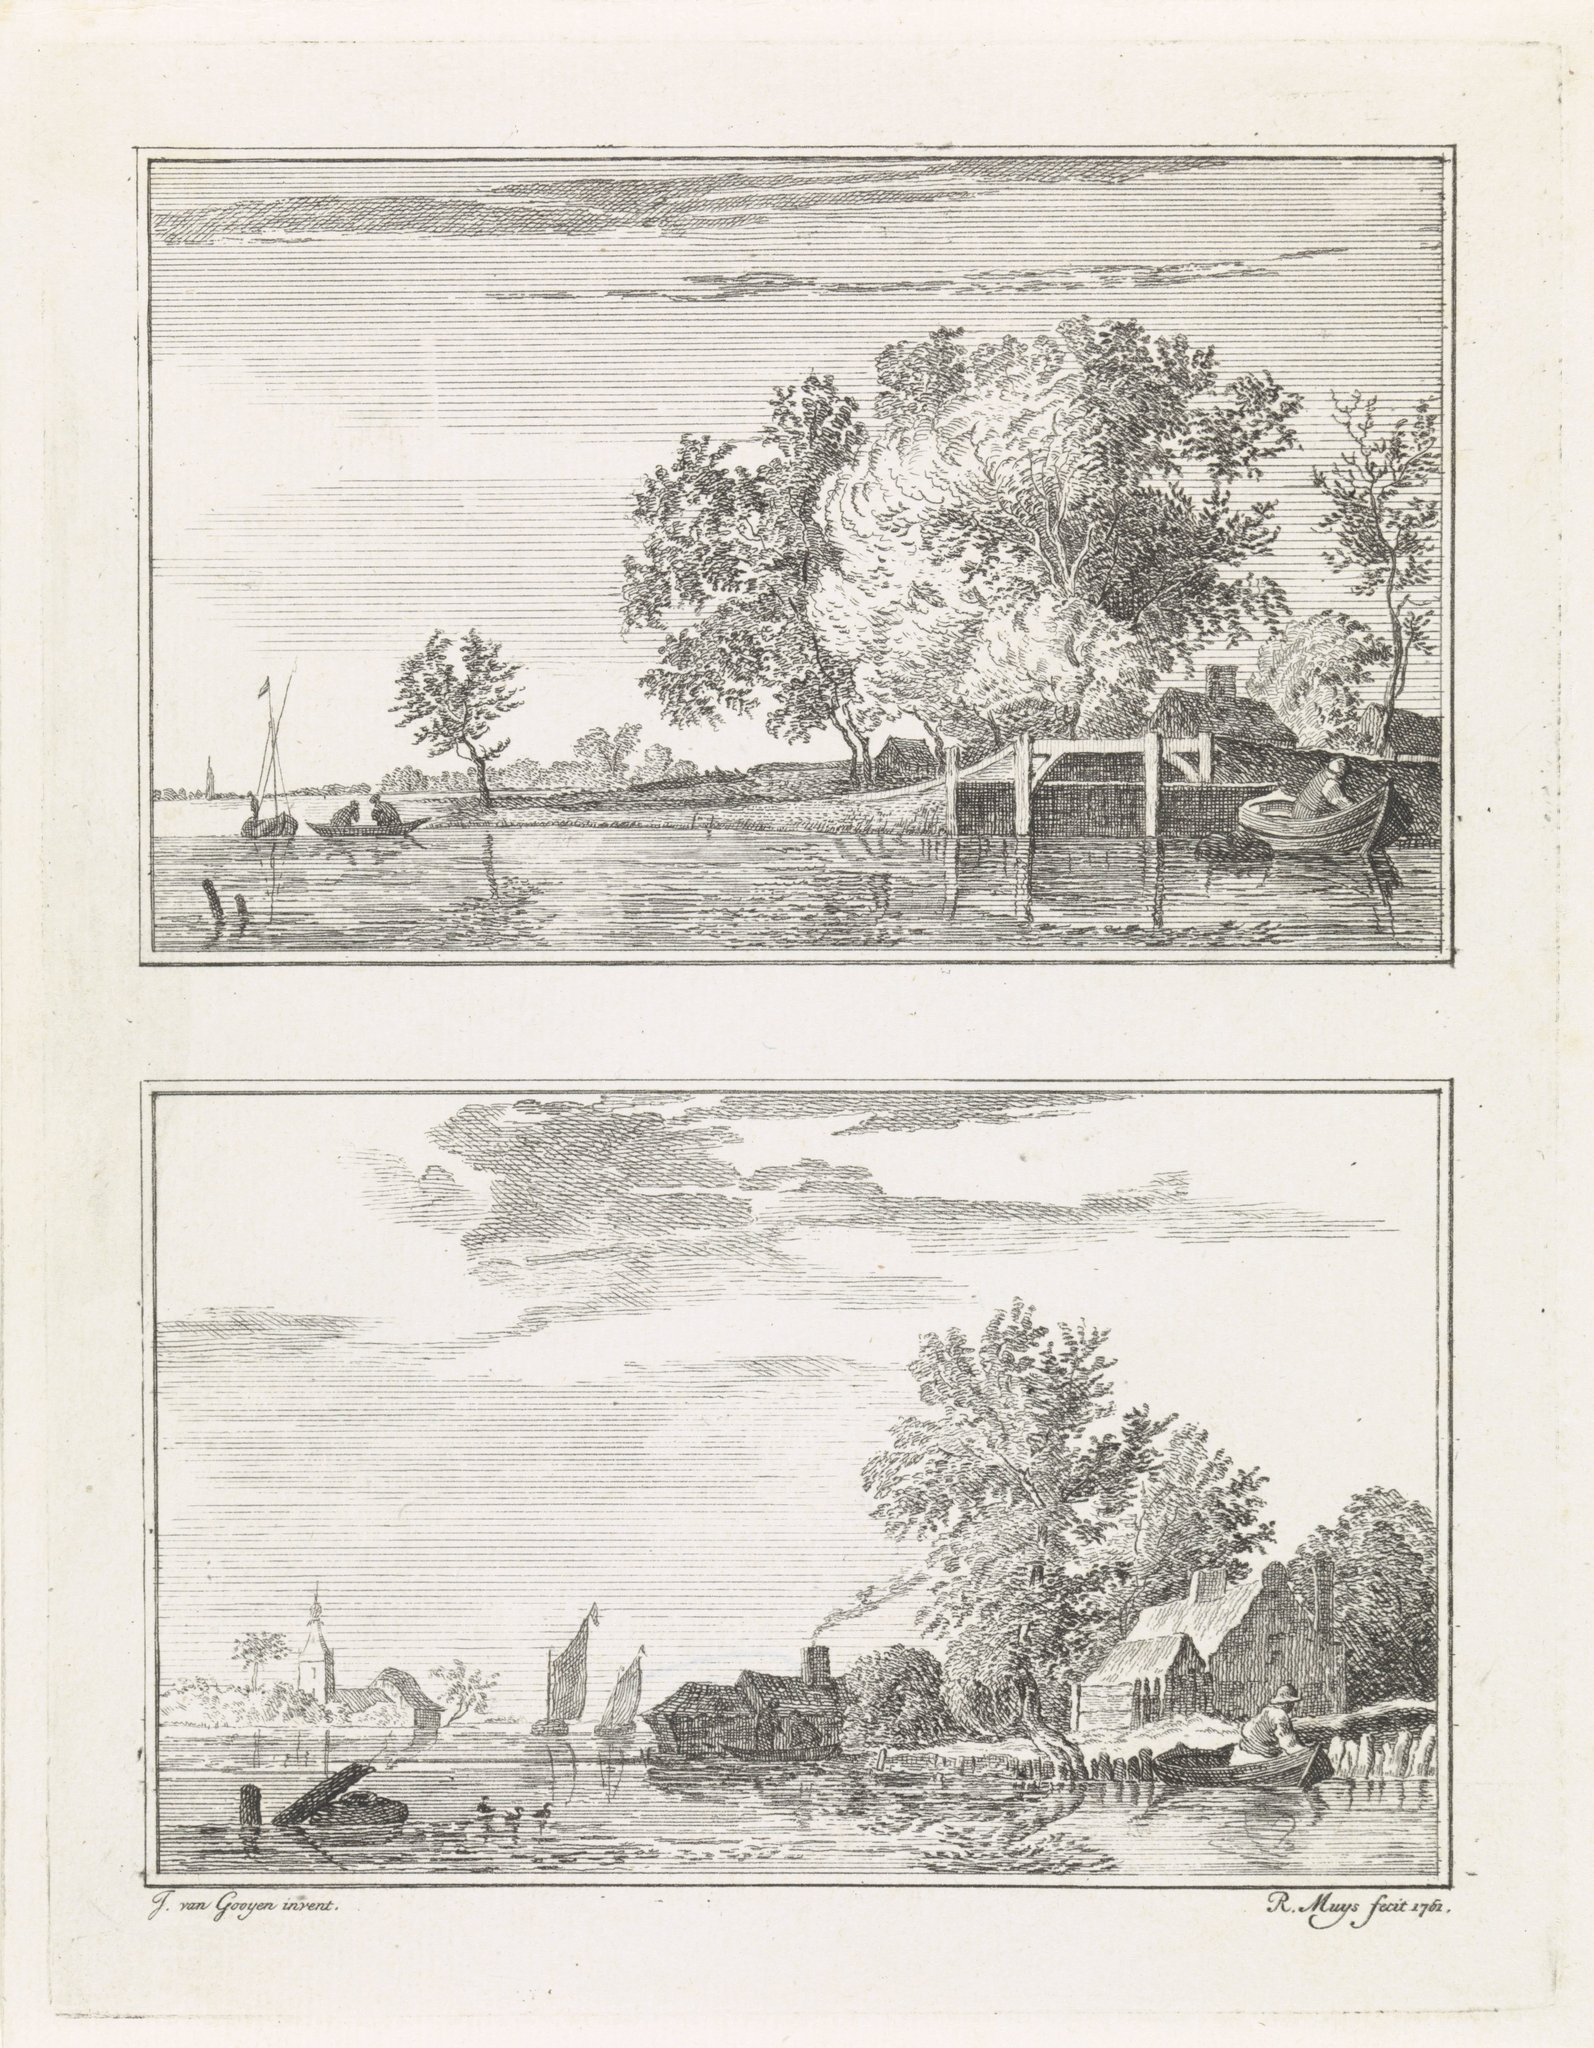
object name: print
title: Twee waterlandschappen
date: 1761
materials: paper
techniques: etching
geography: rotterdam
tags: sailing-ship, sailing-boat, water course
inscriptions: collector's mark: Lugt 2228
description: Twee landschappen onder elkaar op één plaat. In het bovenste landschap links op het water een zeilschip en een roeiboot, hoge bomen en woningen op de kant. Rechts een man in een sloep. In het onderste landschap in het midden twee schepen met gehezen zeil, links een kerktoren op de kant, rechts woningen en geboomte.